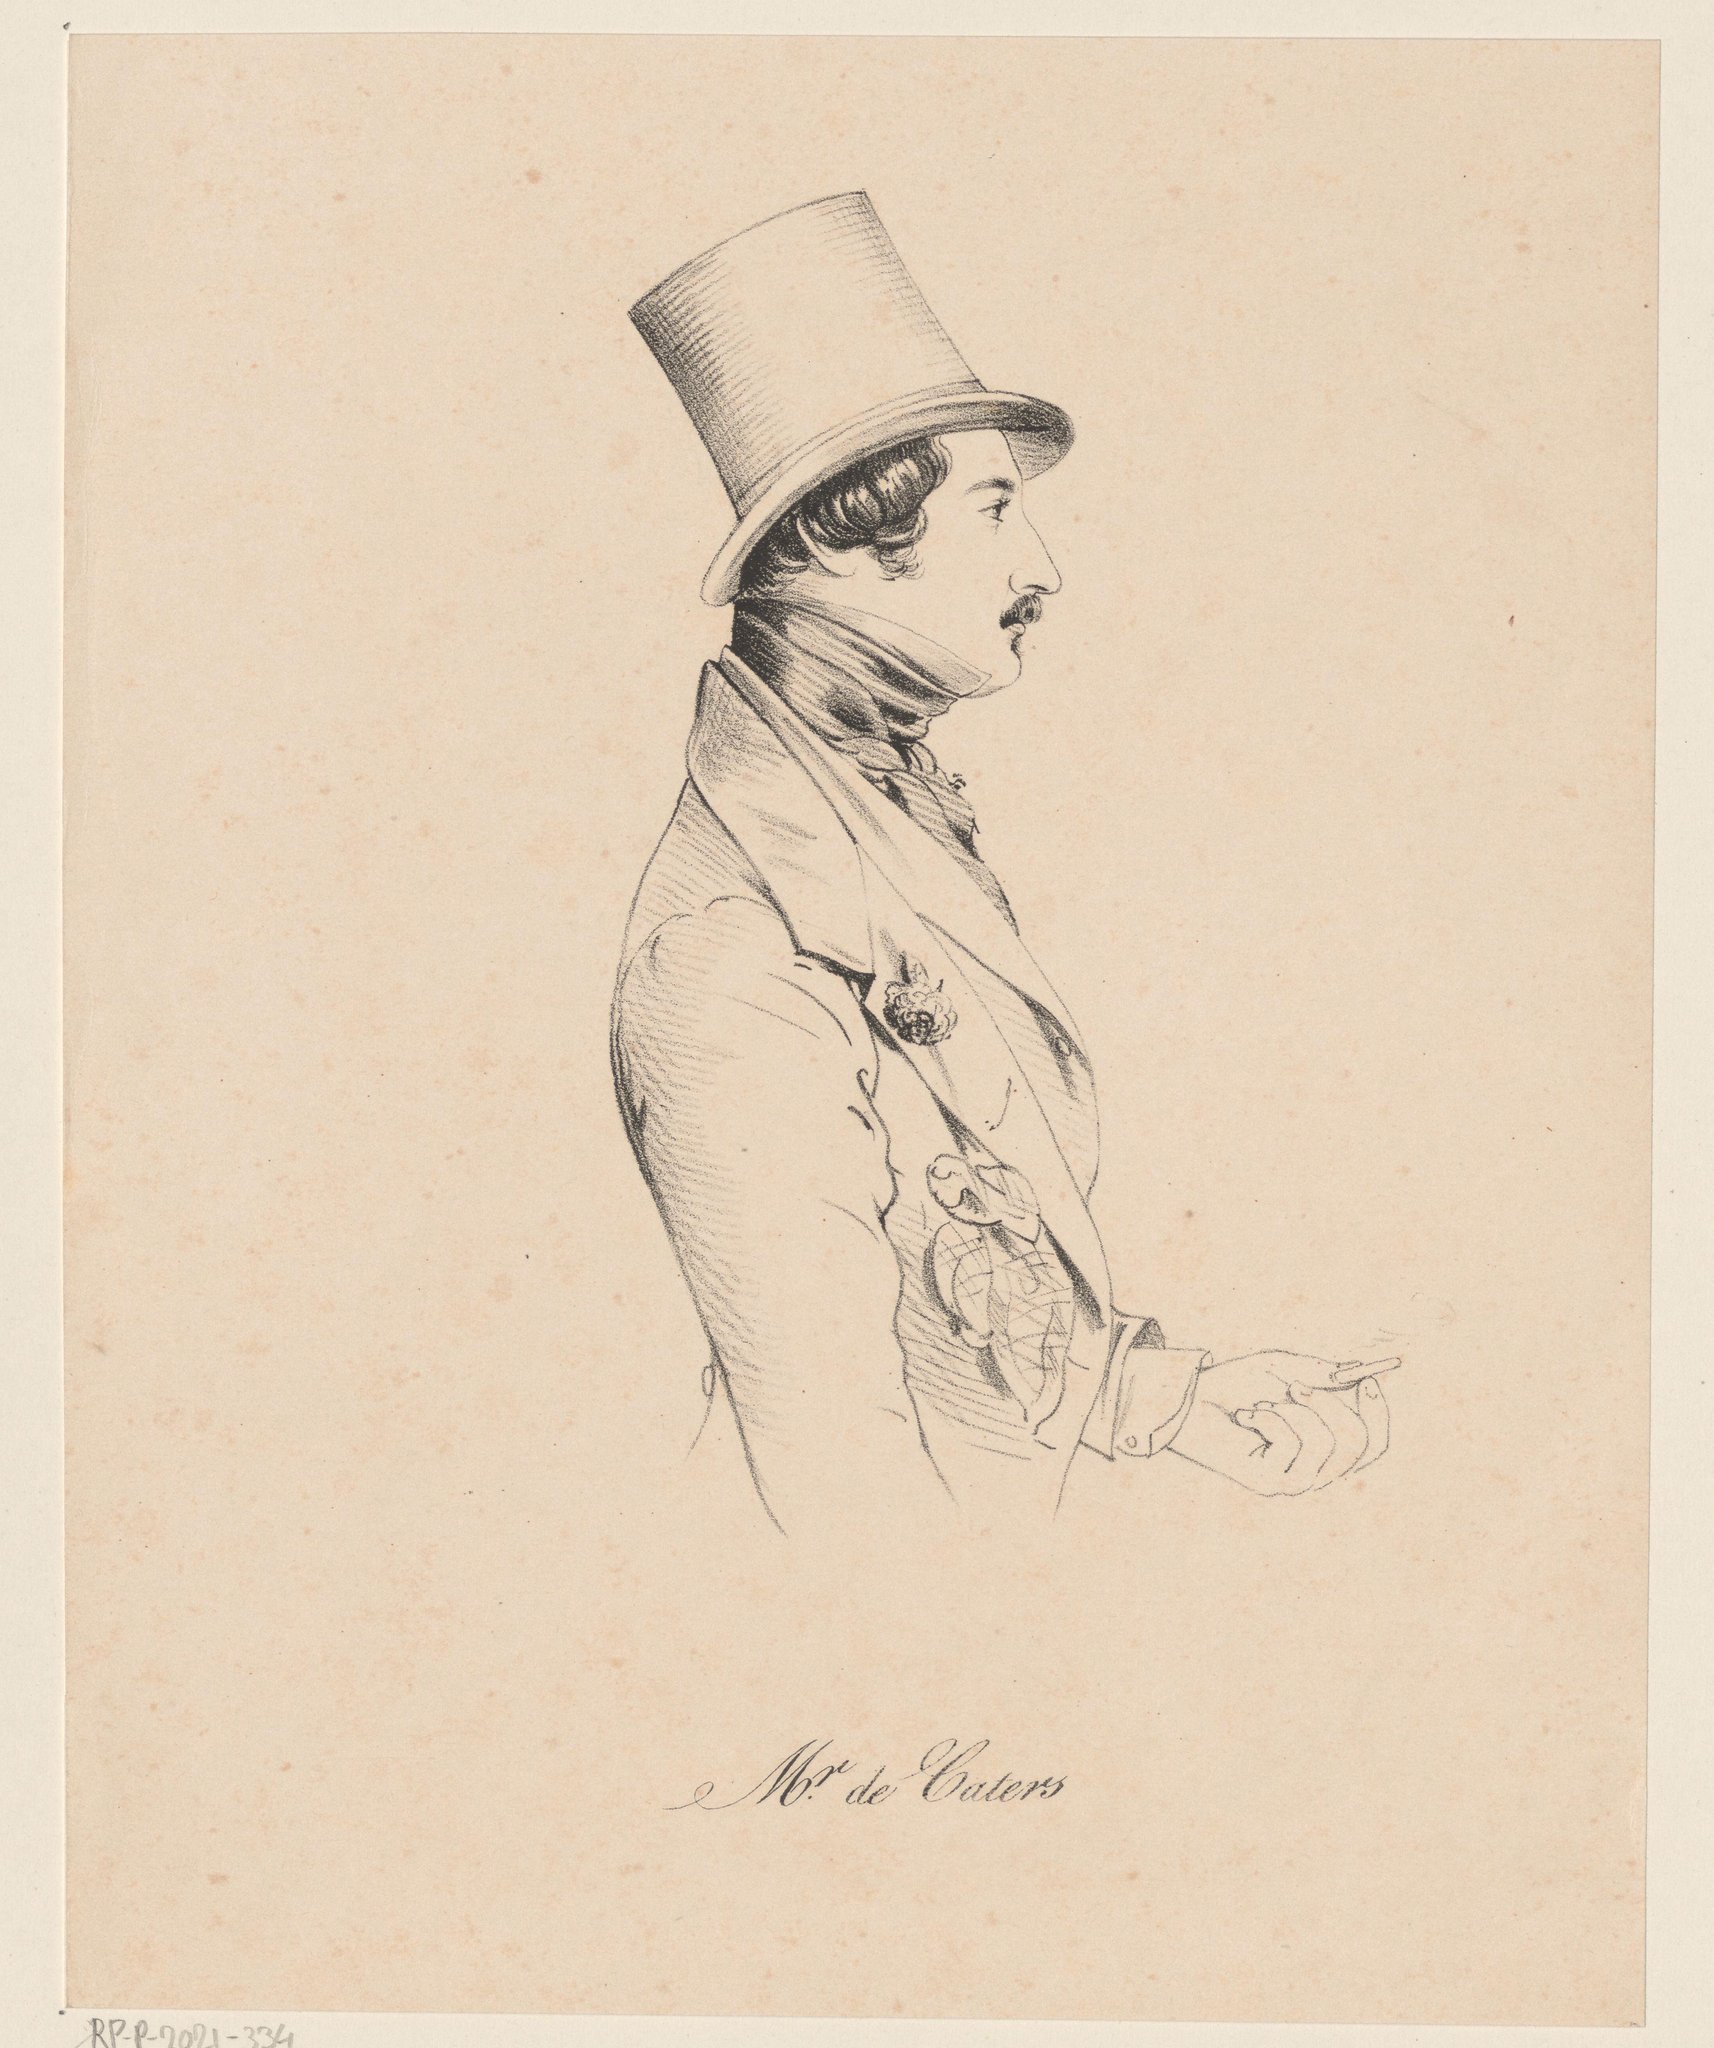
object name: print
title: Portret van Mr. de Caters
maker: Anonymous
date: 1795-1899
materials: paper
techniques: lithograph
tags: historical persons